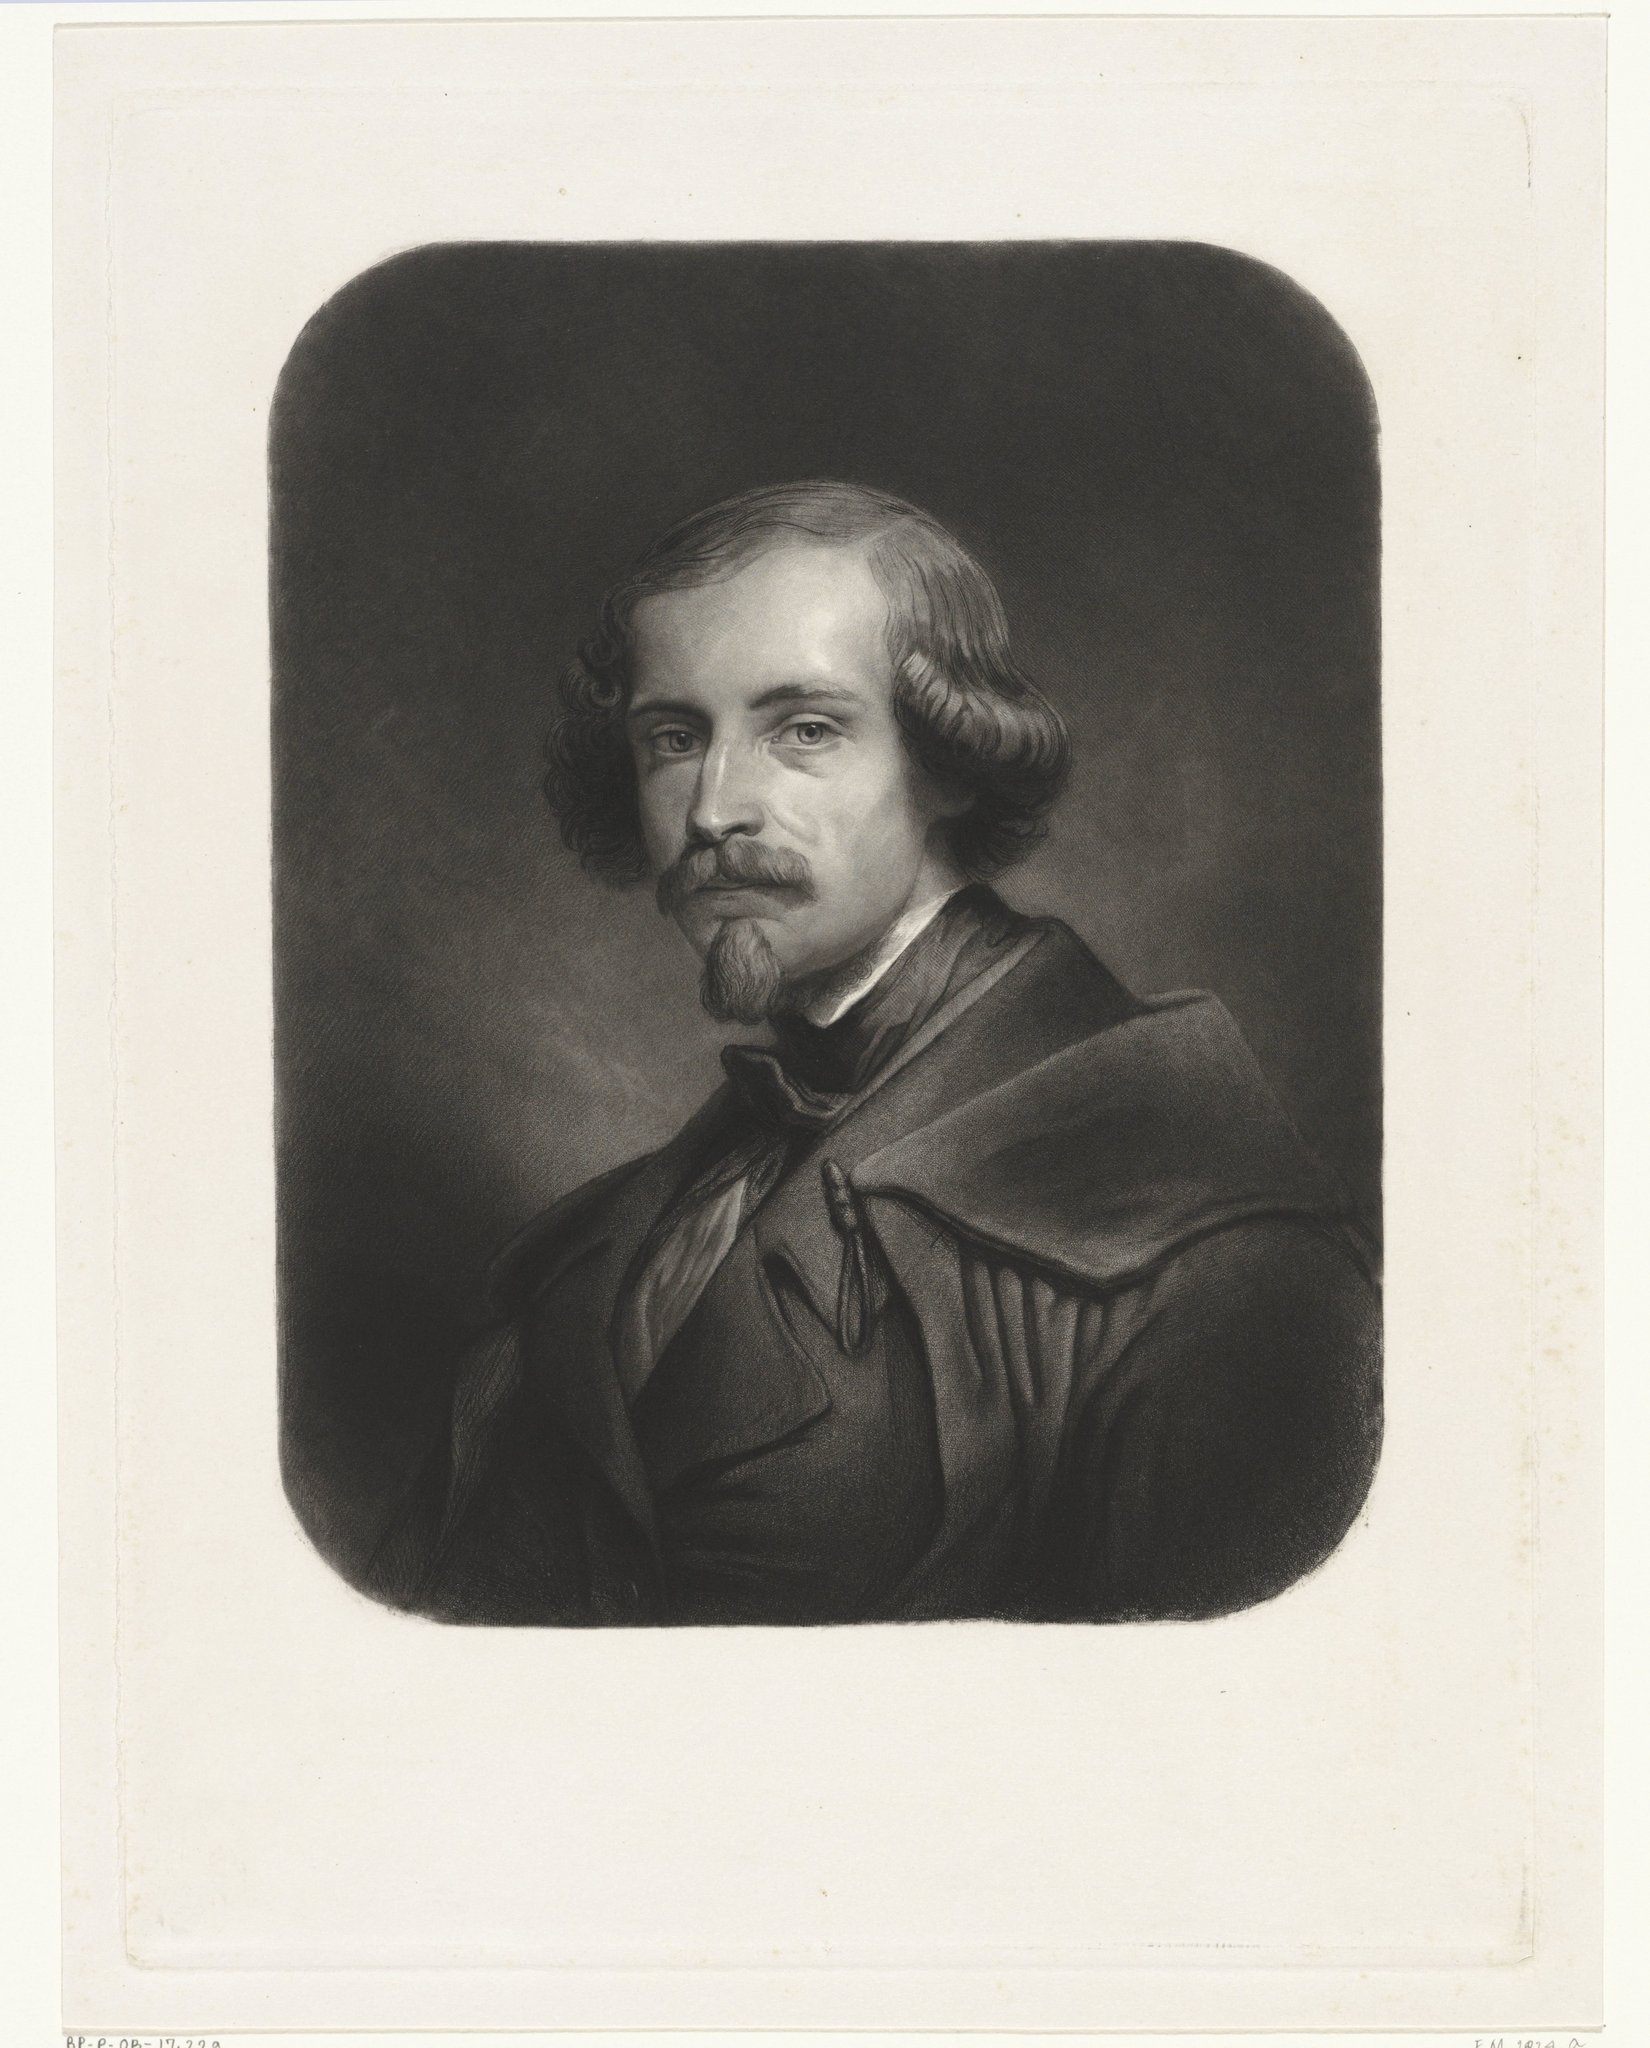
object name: print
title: Zelfportret van Johann Wilhelm Kaiser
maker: johann wilhelm kaiser (i)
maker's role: draughtsman, print maker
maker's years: 1813-1900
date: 1825-1853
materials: paper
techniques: engraving, etching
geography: amsterdam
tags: leiden, print maker, johann wilhelm kaiser (i), portrait, self-portrait of artist